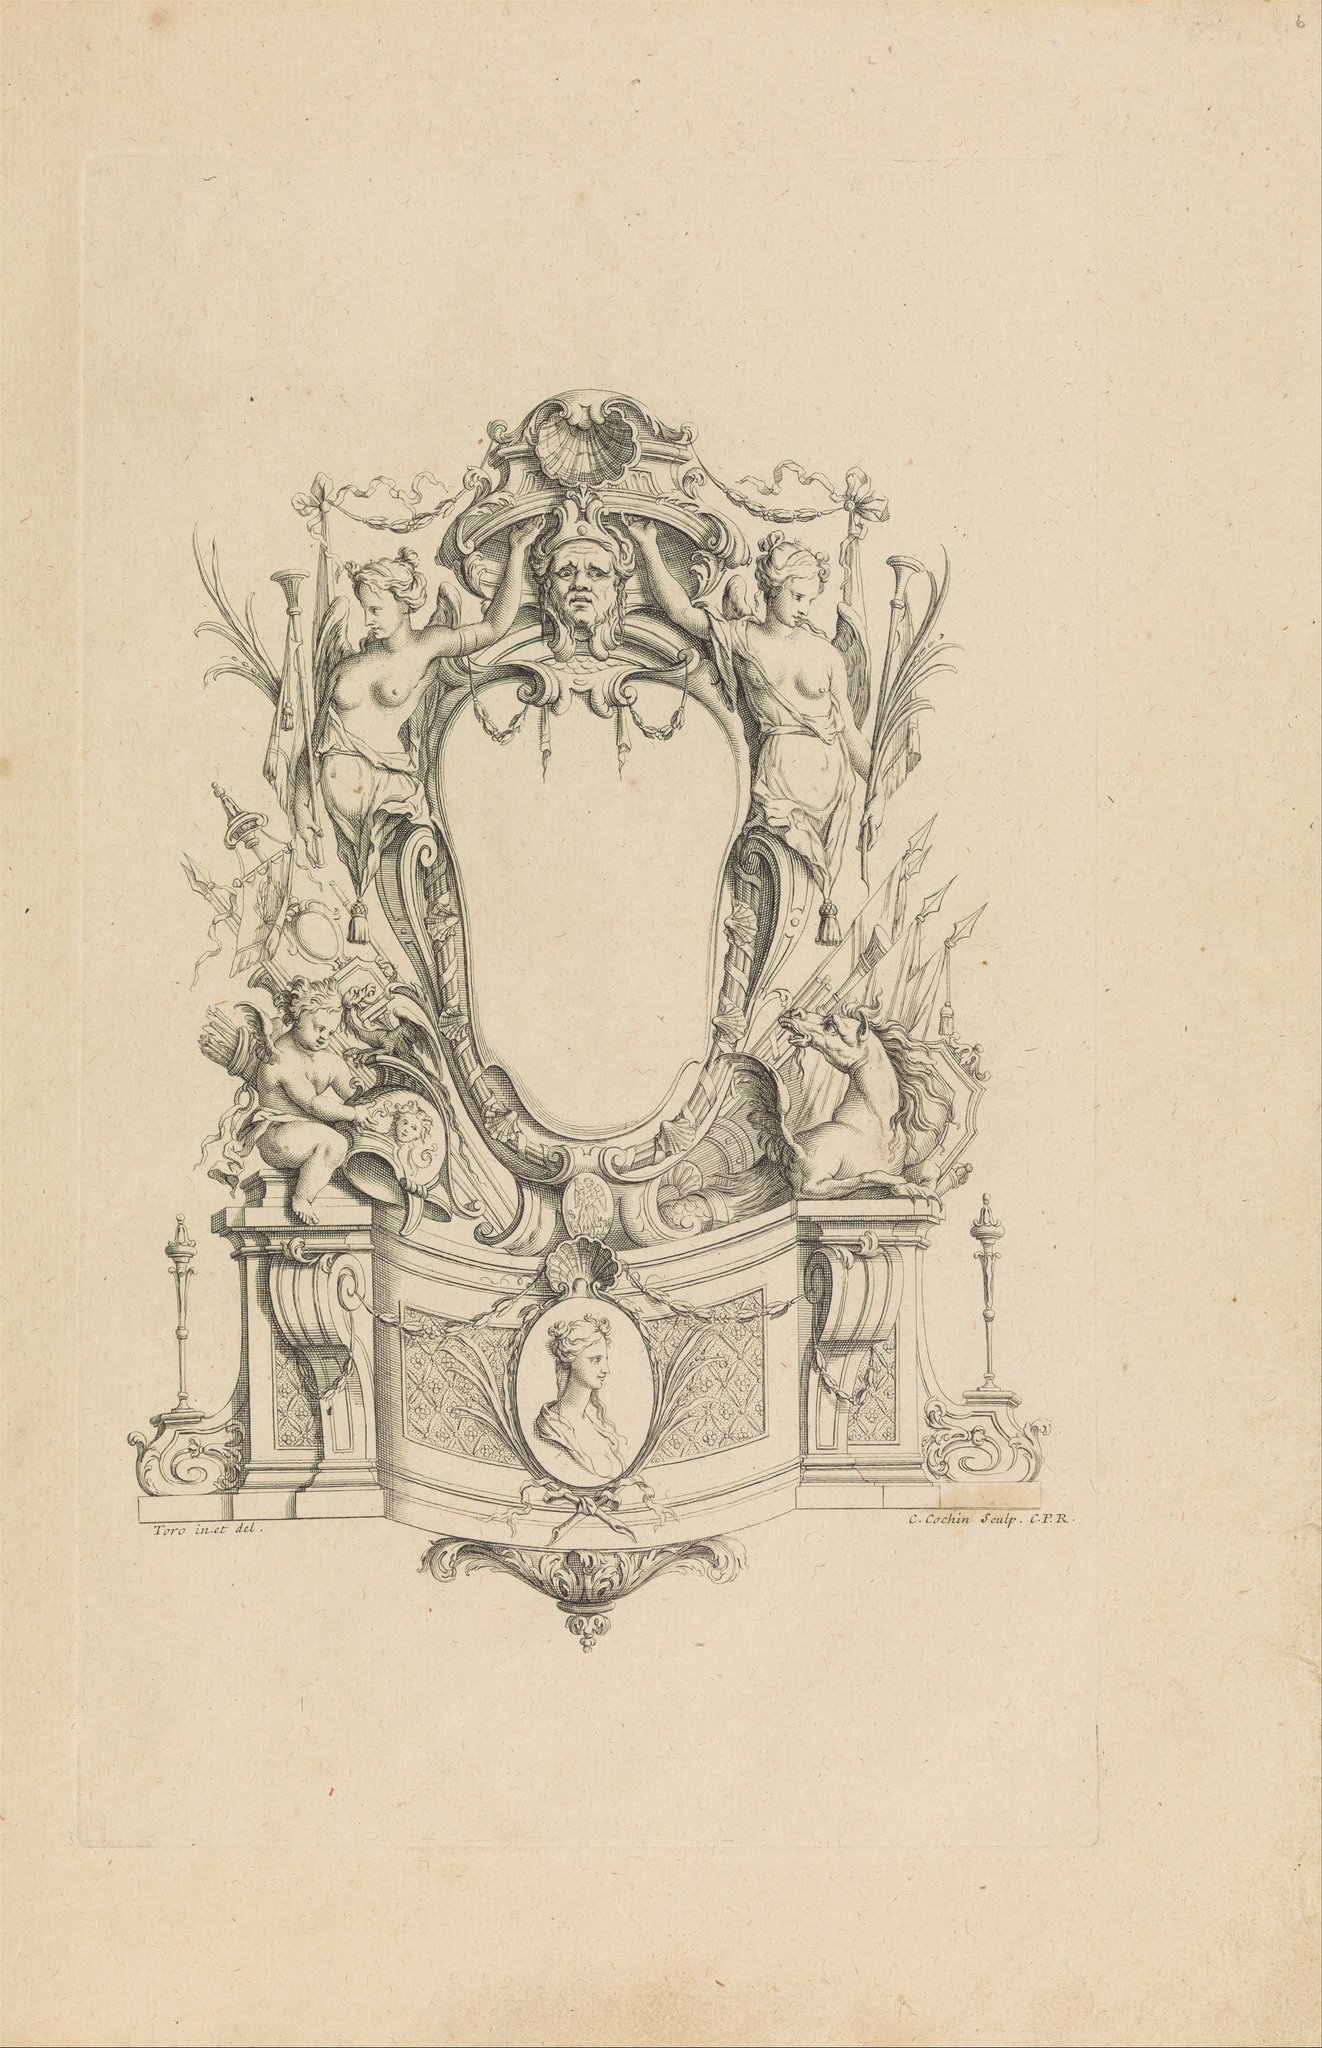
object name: album print ornament architecture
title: Cartouches Nouvellement Inventez par J.B. Toro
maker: jean bernard toro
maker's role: designer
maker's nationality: french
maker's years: 1672-1731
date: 1716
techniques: etching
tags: cartouches,grotesques,ornament,mythical creatures